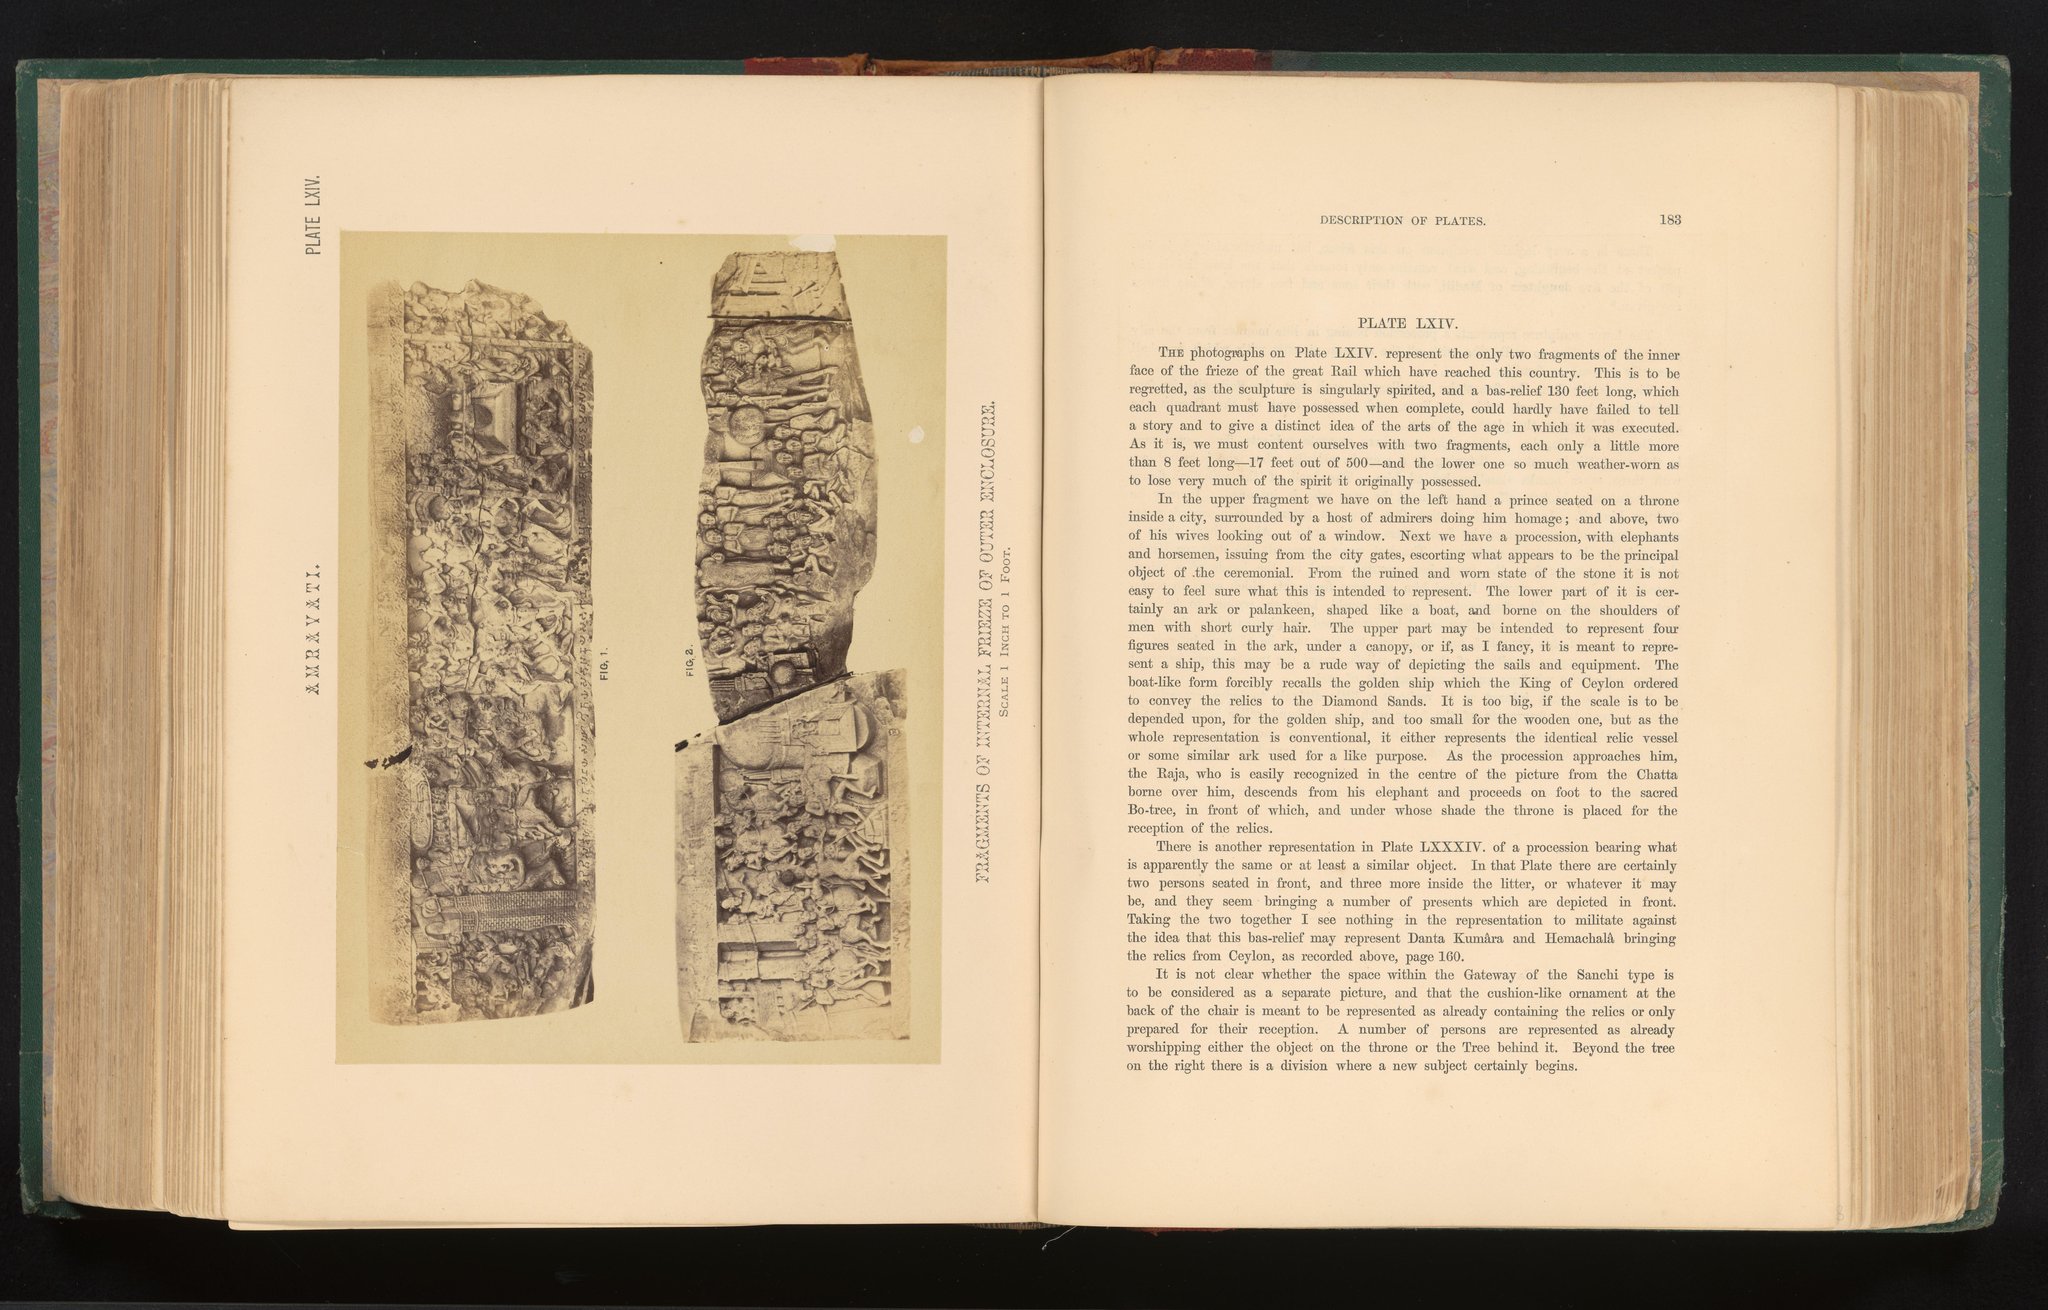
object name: photograph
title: Two fragments of a frieze with relief, Amaravati, Andhra Pradesh, India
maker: william h. griggs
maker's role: printer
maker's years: 1832-1911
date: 1863-1868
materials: photographic support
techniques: albumen print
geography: amaravati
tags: hinduism, buddhism, jainism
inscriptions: inscription: ‘FRAGMENTS OF INTERNAL FRIEZE OF OUTER ENCLOSURE./ SCALE 1 INCH TO 1 FOOT.’, inscription: ‘AMRAVATI. PLATE LXIV.’